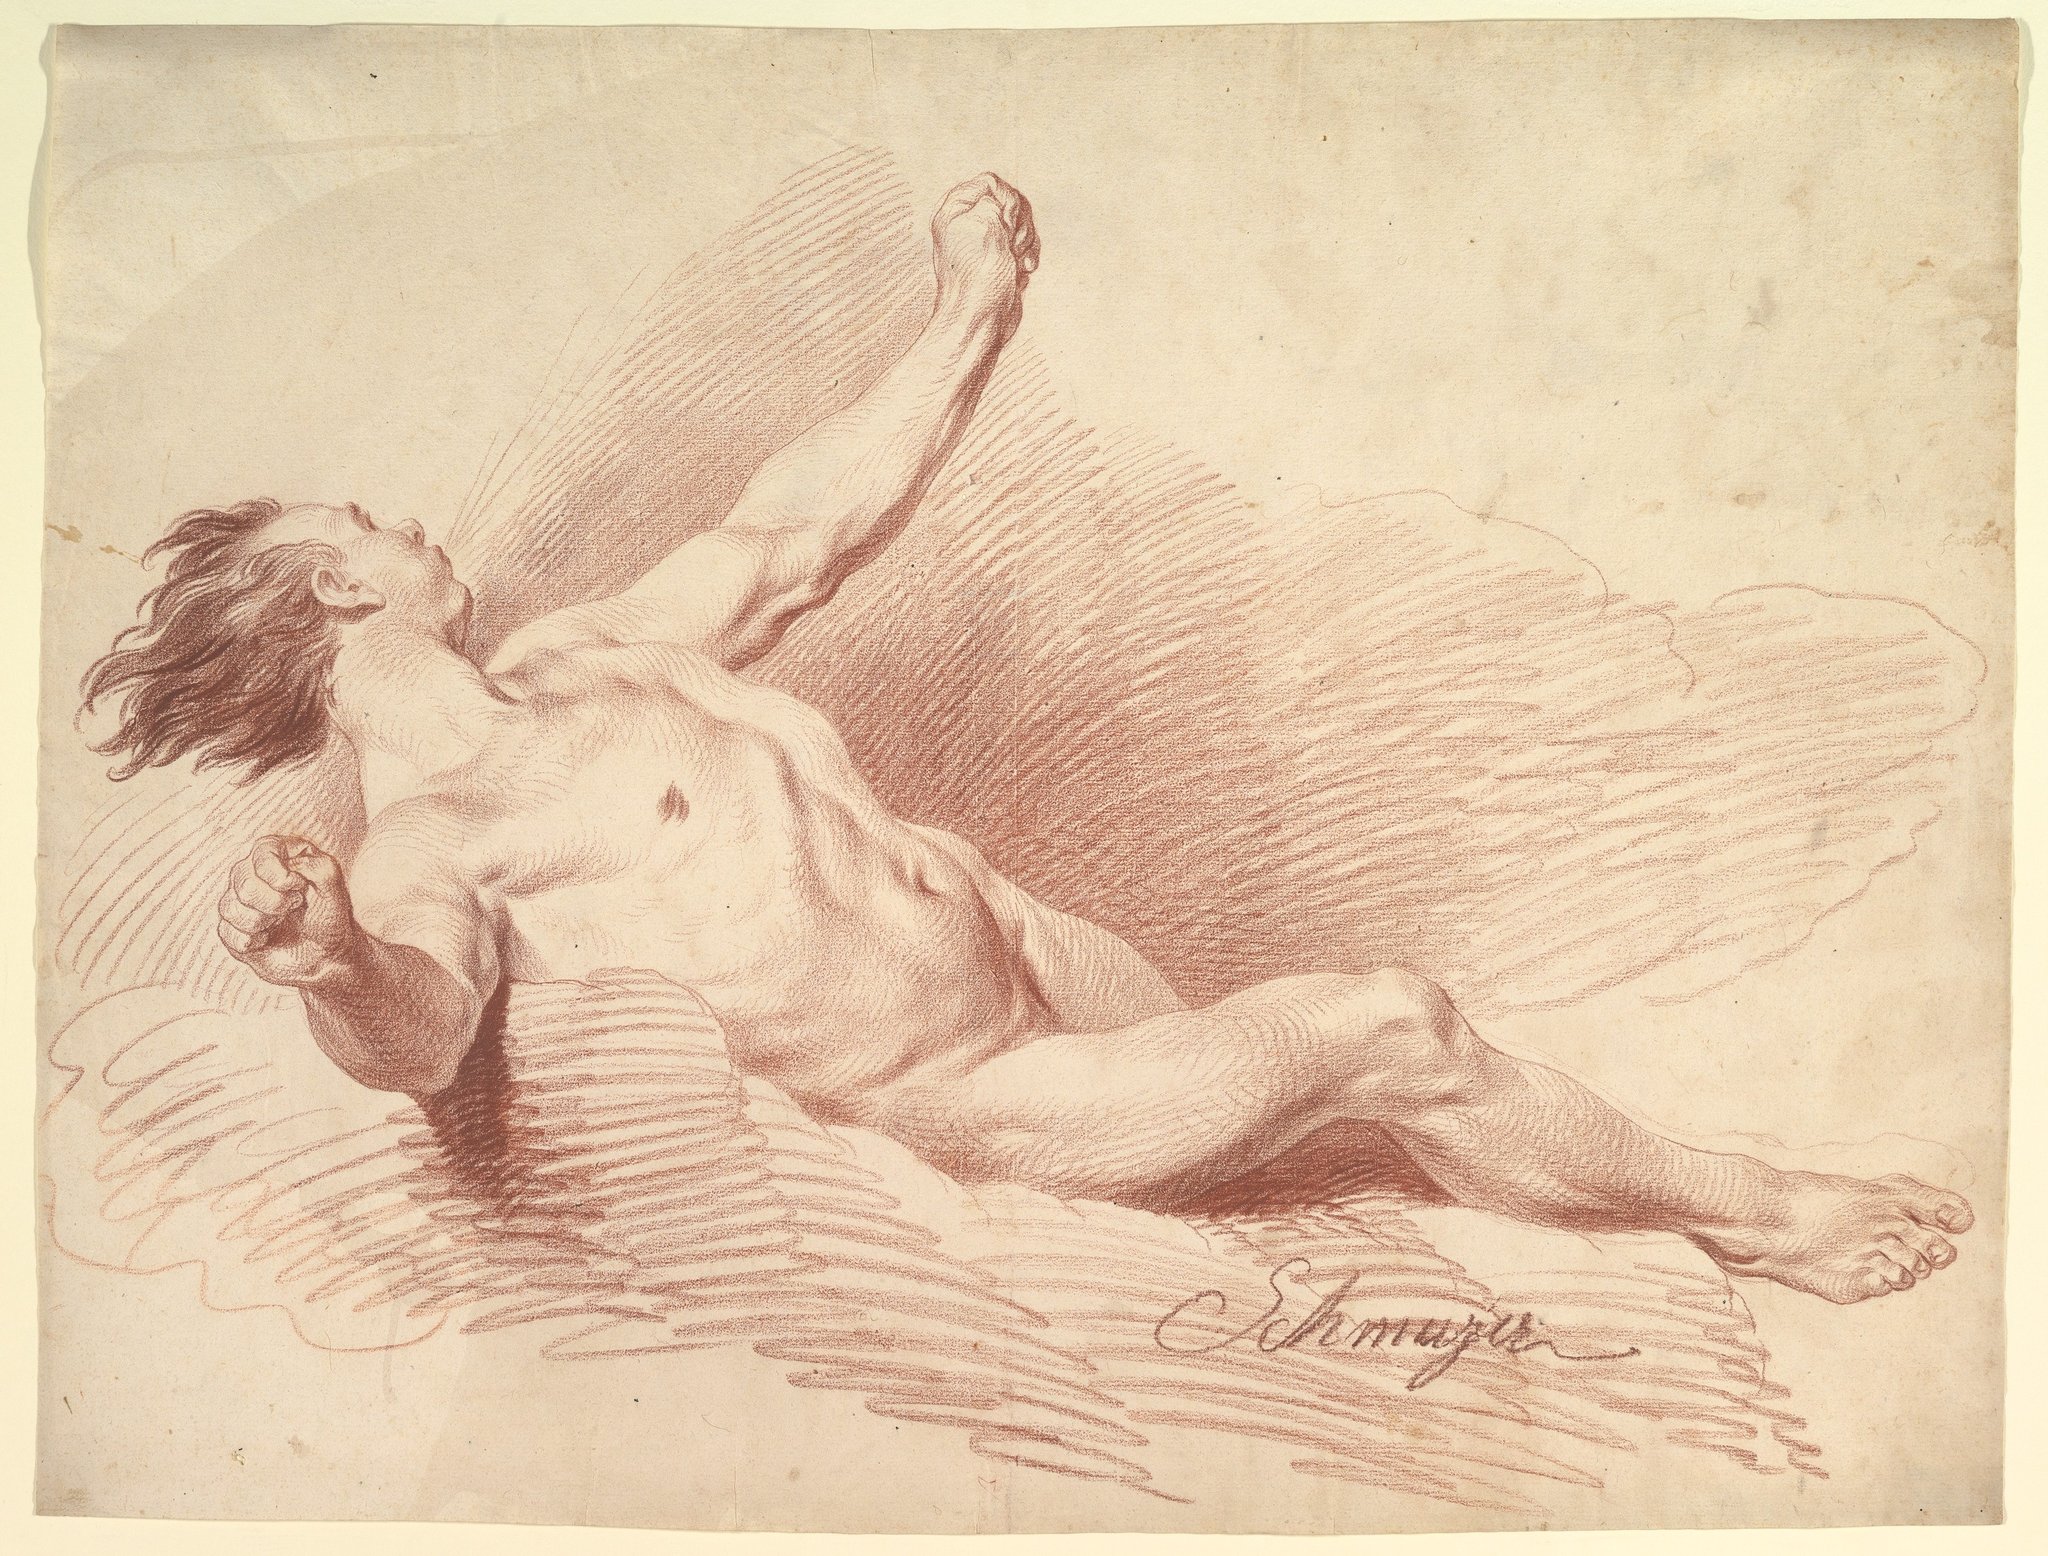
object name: drawing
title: Reclining Male Nude, as Wind God on Clouds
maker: jakob matthias schmutzer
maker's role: artist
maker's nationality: austrian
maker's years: 1733-1811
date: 1765-1810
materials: chalk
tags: male nudes